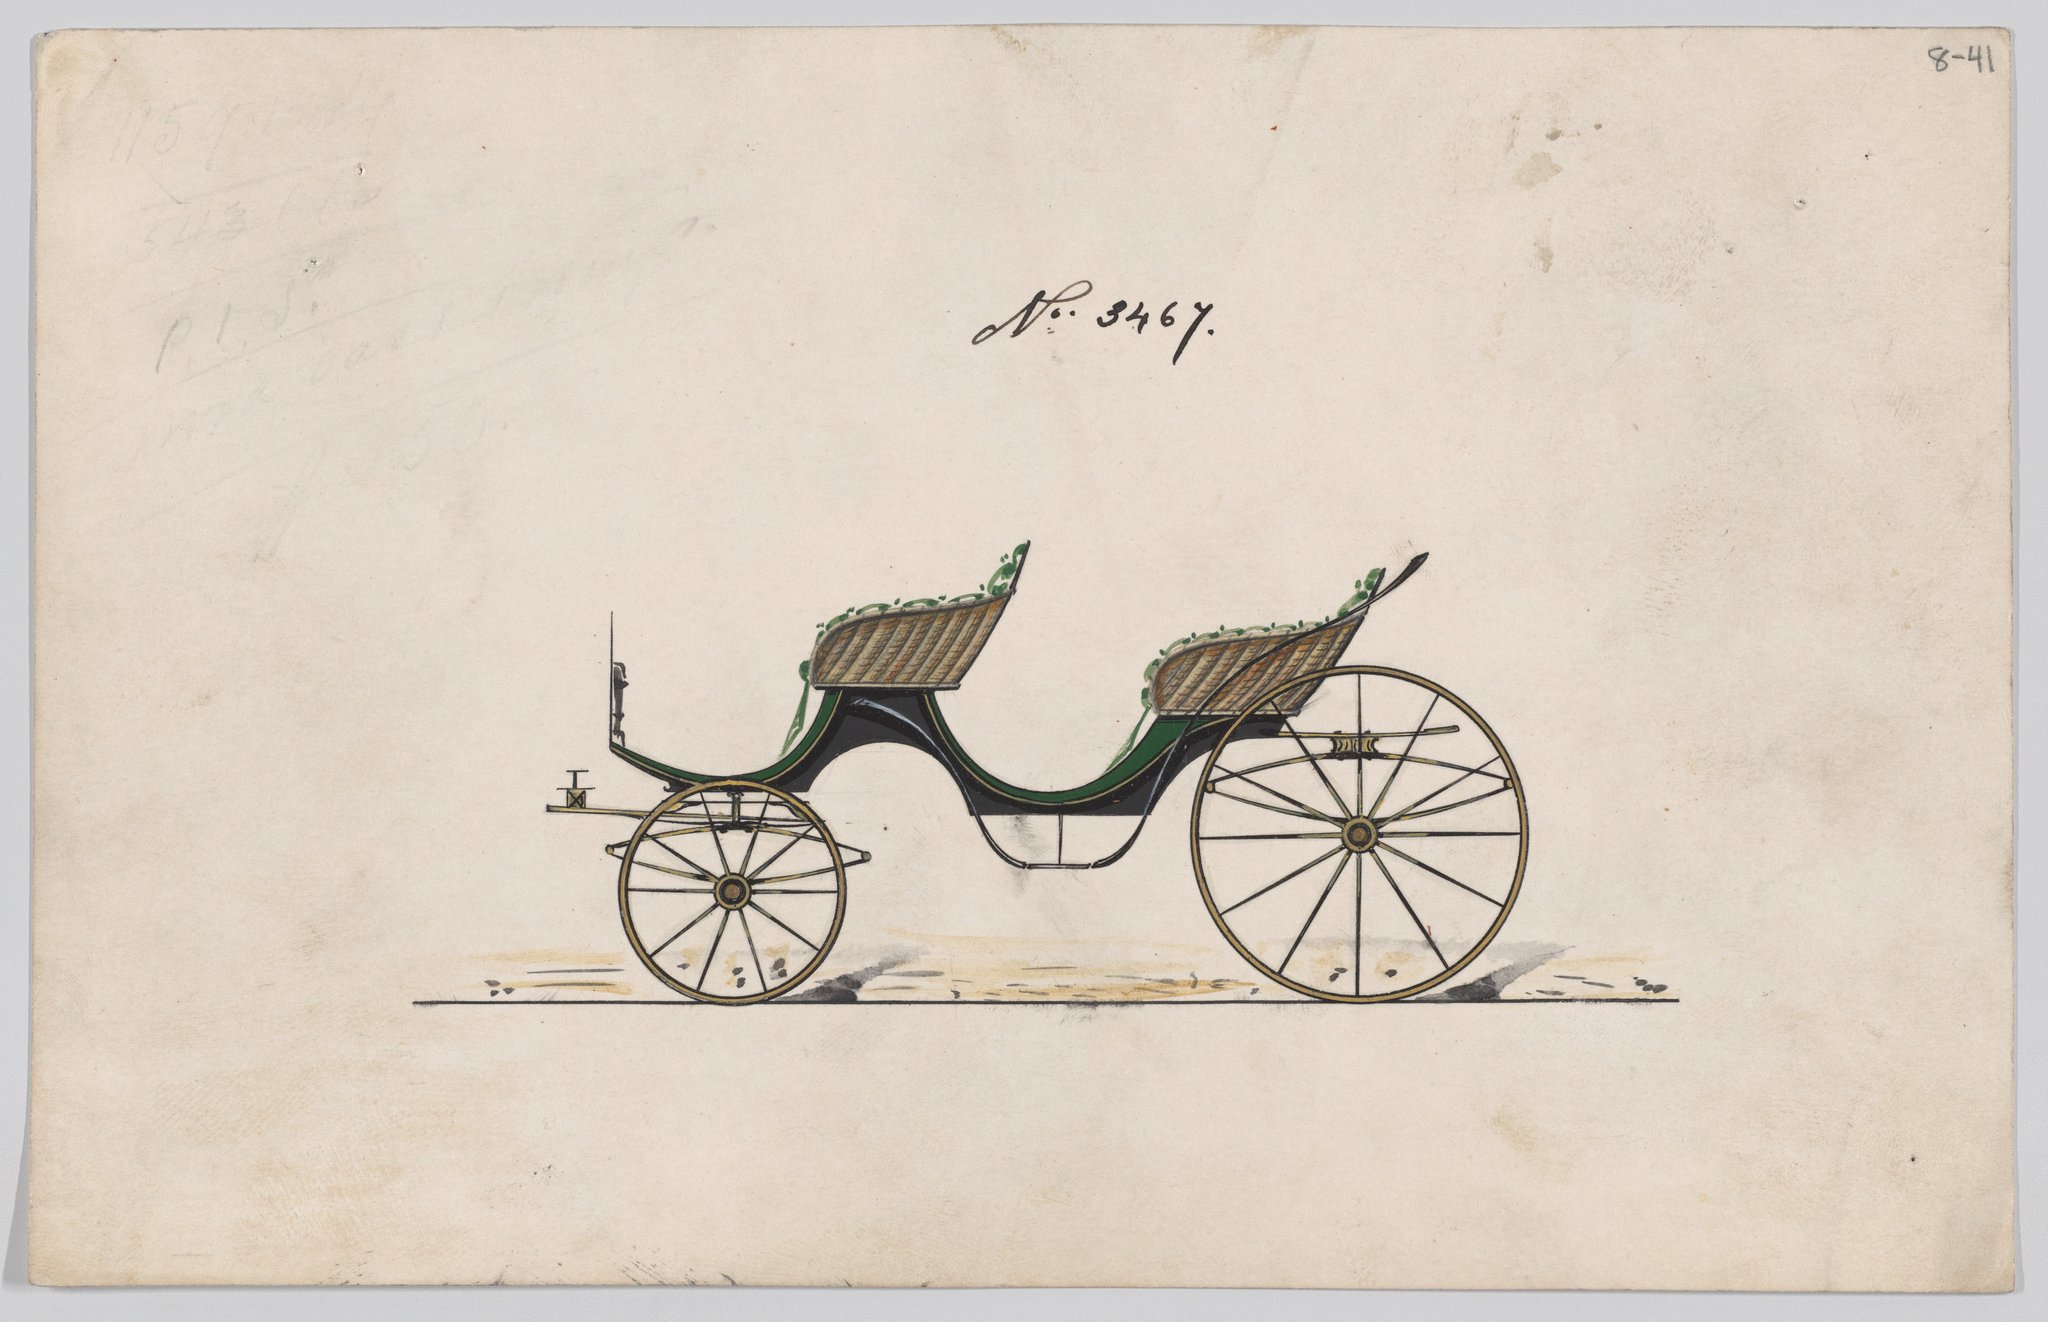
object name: drawing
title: Design for 4 seat Phaeton, no top, no. 3467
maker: brewster & co.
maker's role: manufacturer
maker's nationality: american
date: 1878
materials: gouache, gum arabic, ink, watercolor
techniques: pen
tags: carriages